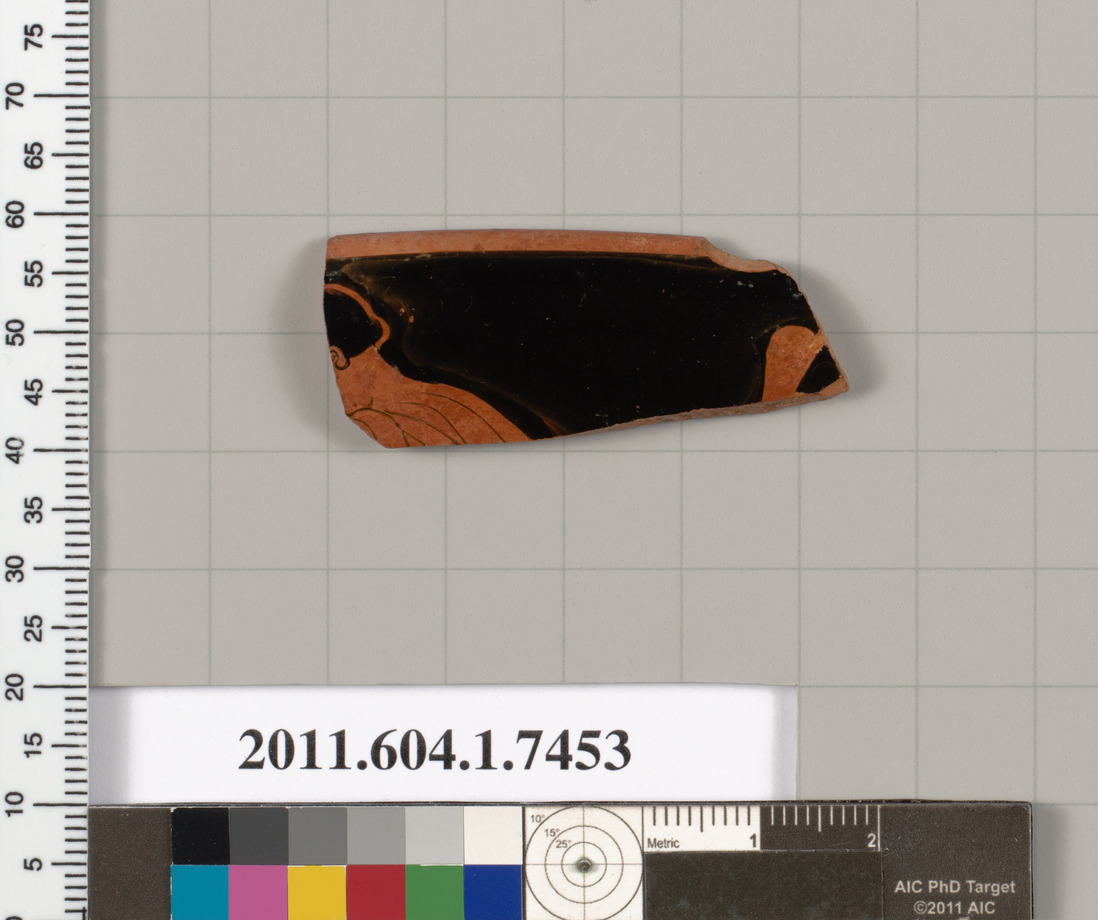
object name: kylix fragment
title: Terracotta rim fragment of a kylix (drinking cup)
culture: greek, attic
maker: hermonax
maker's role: artist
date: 470-460 BCE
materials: terracotta